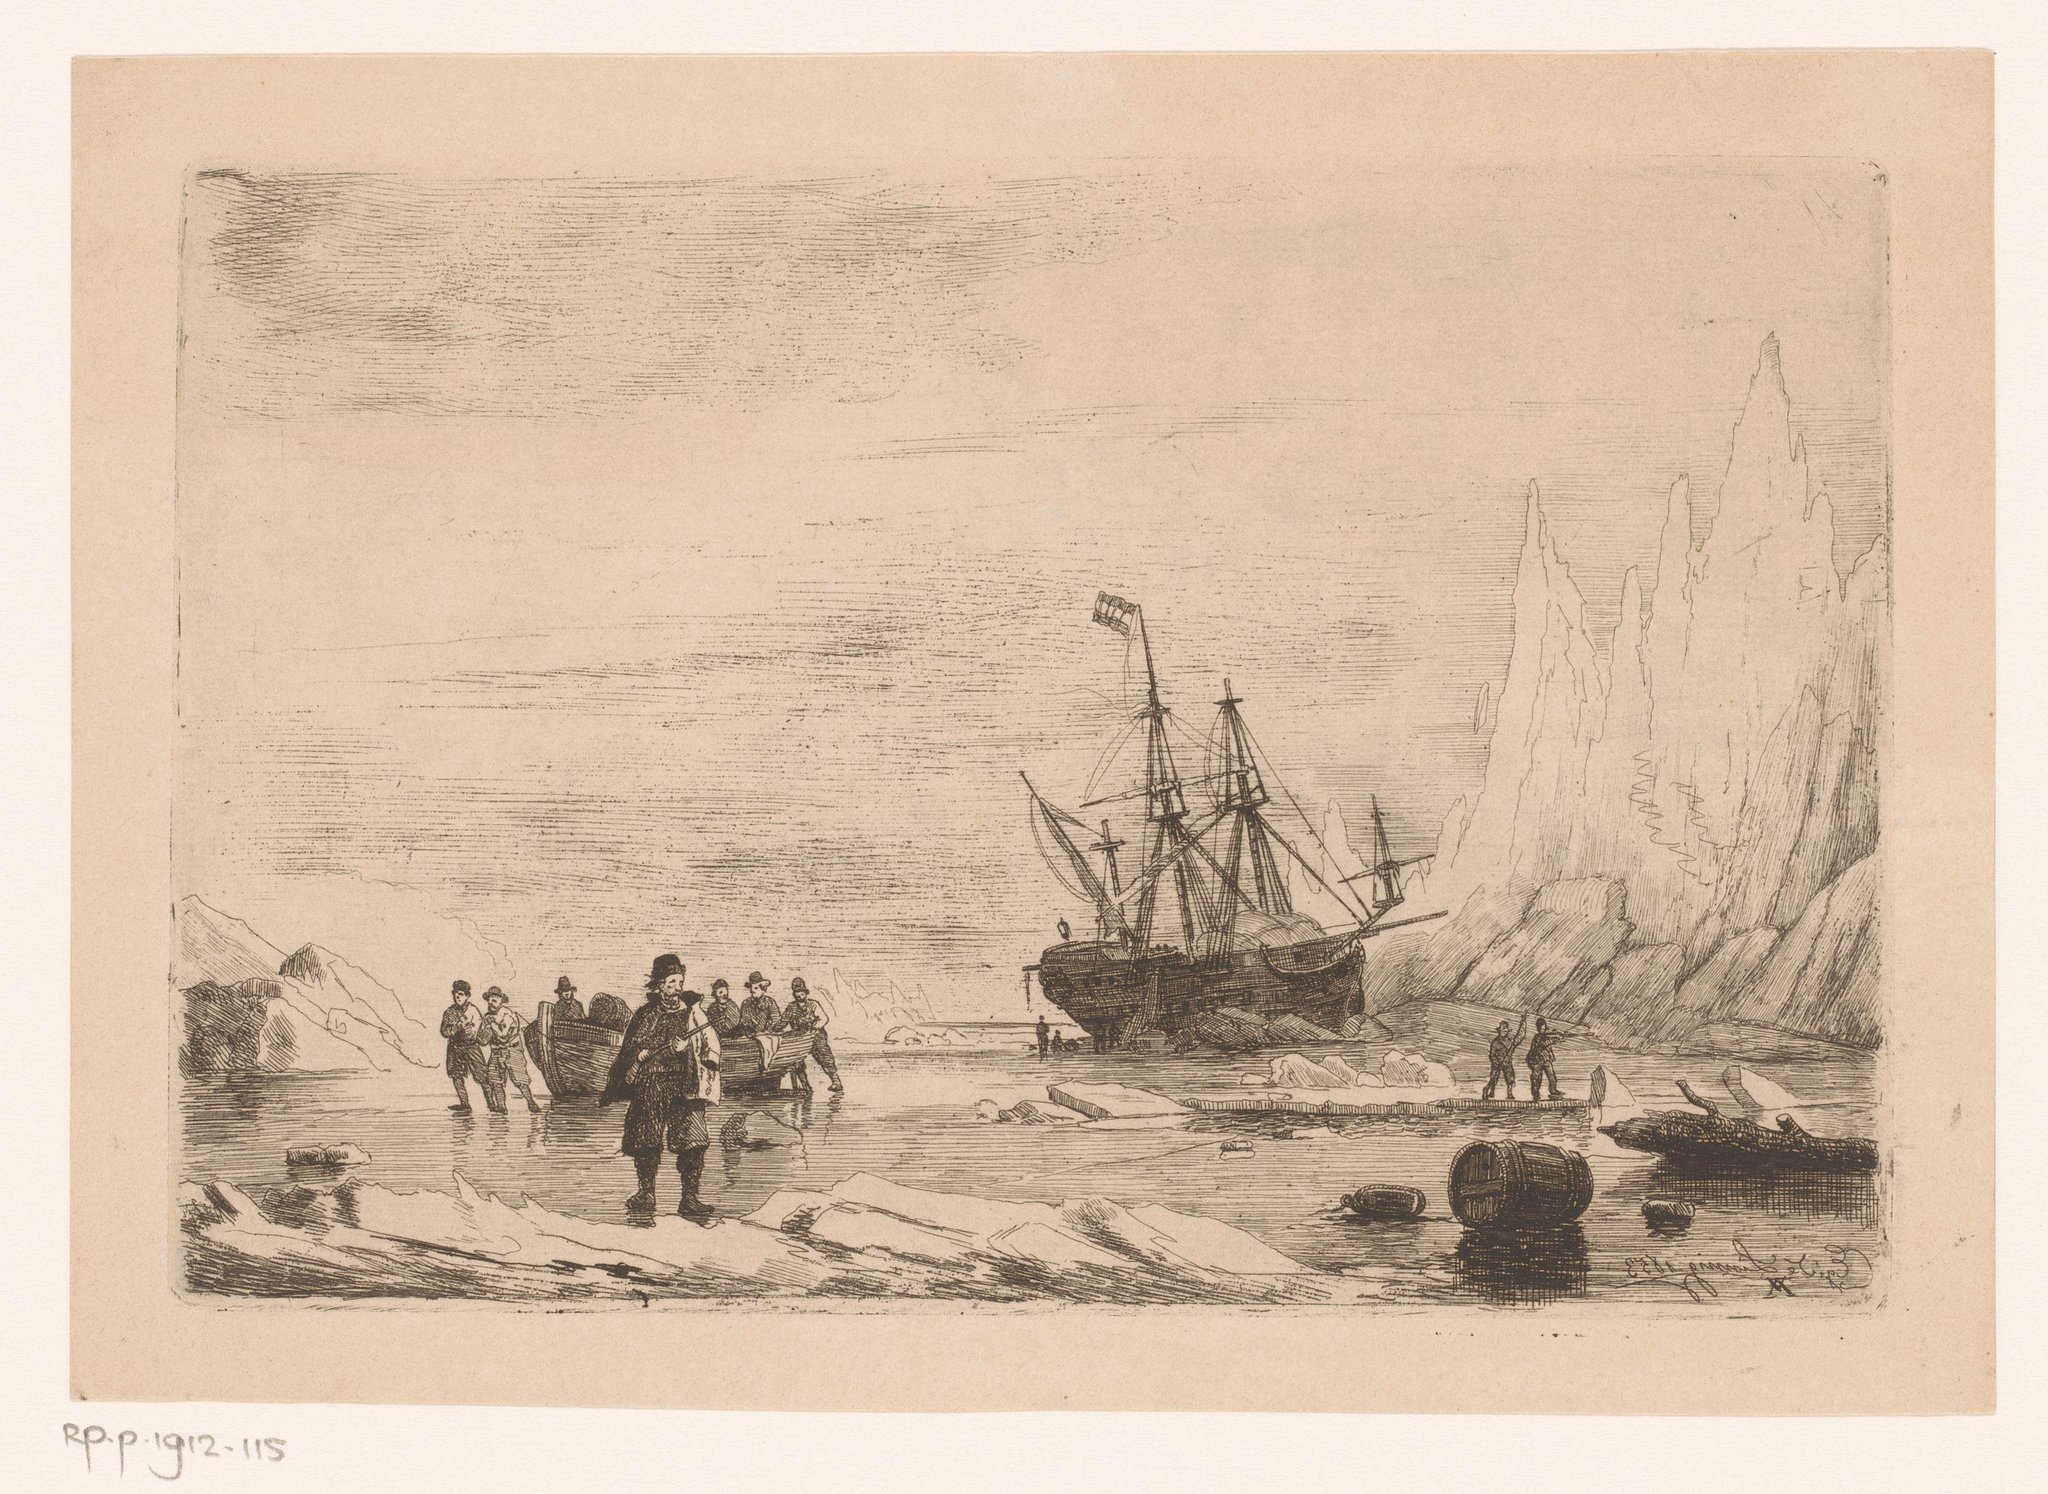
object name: print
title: Overwintering op Nova Zembla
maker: egidius linnig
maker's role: draughtsman, print maker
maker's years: 1821-1860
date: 1853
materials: paper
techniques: etching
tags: shipwreck, landscapes in polar regions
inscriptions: collector's mark: Lugt 2228, collector's mark: Lugt 1485